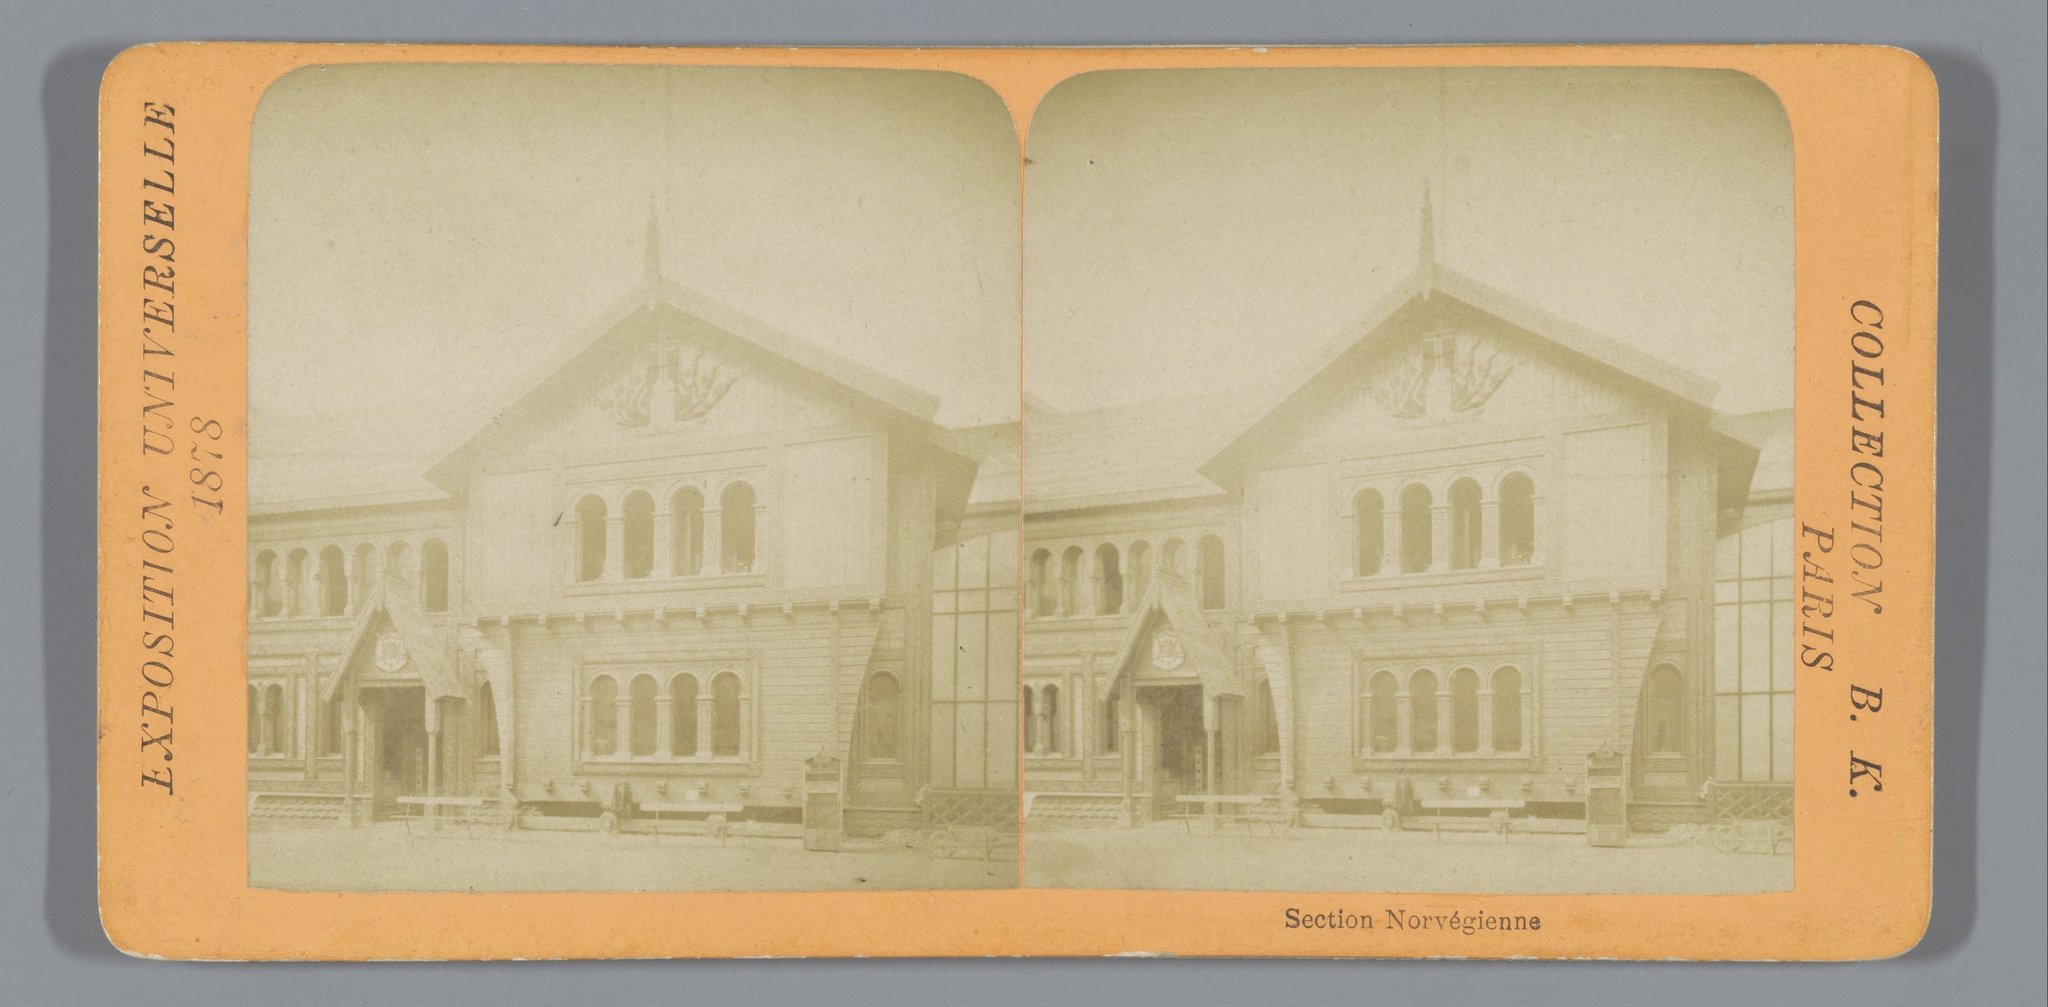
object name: stereograph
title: Section Norvegienne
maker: adolphe block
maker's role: publisher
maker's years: 1829-1918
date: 1878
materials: cardboard, paper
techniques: albumen print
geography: paris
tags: world fair, world exhibition, exterior ~ representation of a building, paris